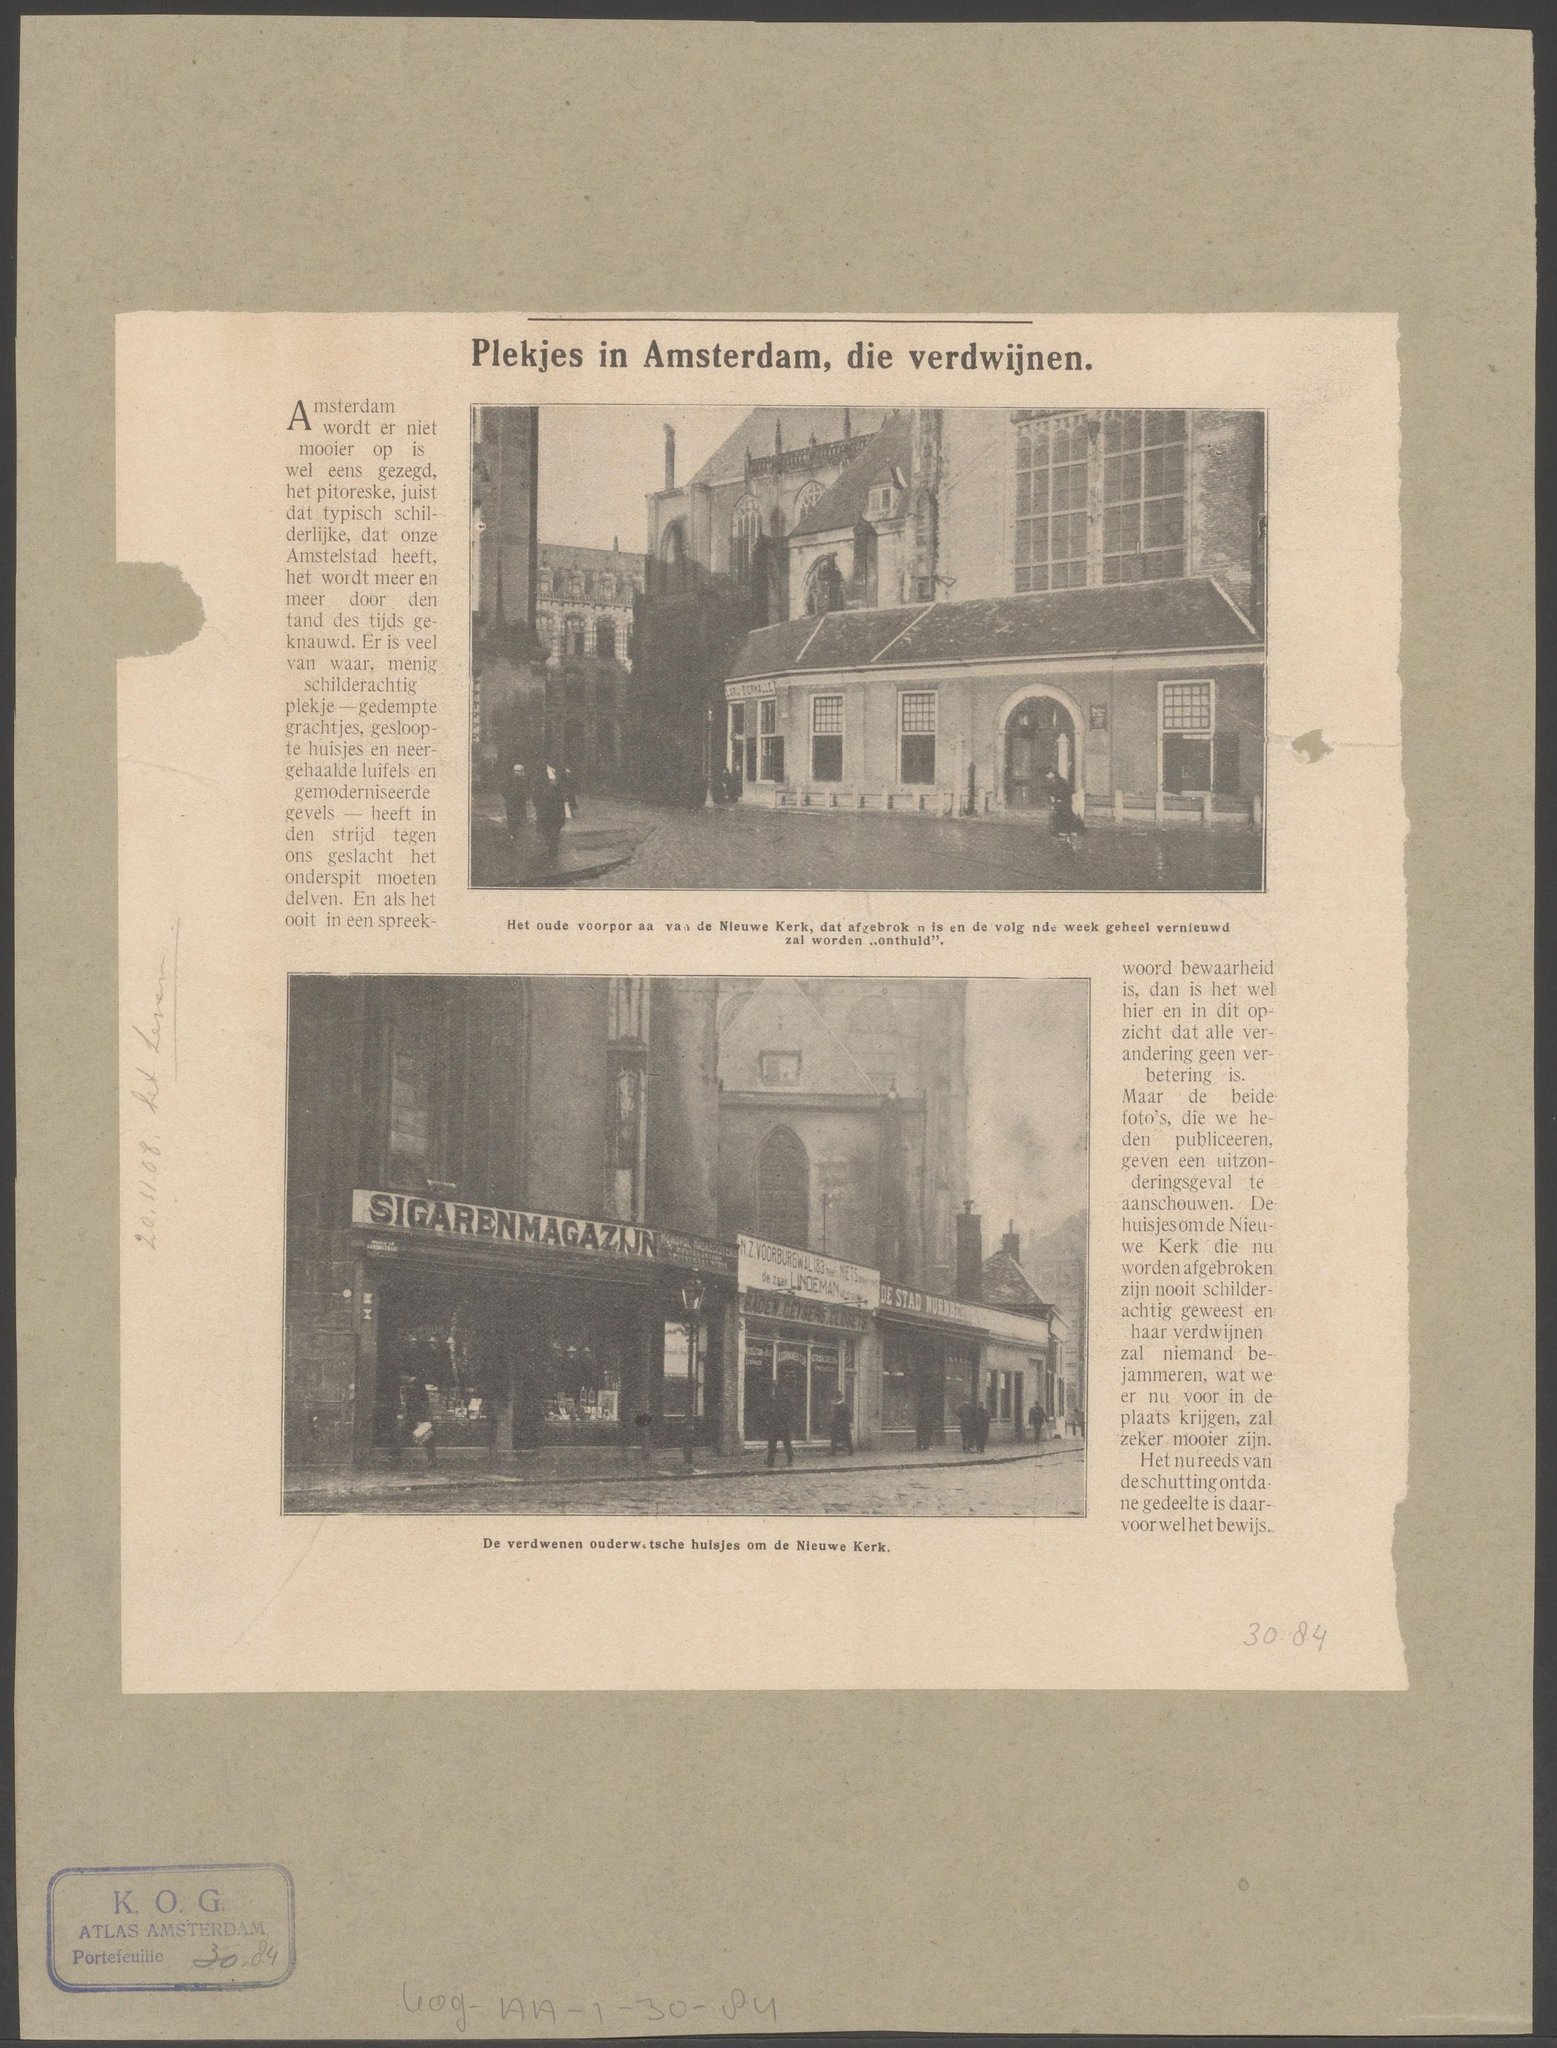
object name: photomechanical print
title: Gezicht op de Nieuwe Kerk te Amsterdam en aanpalende gebouwen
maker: Anonymous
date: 1908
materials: paper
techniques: letterpress printing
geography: netherlands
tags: parts of church exterior and annexes: portal, shop, store, church (exterior), street (+ city(-scape) with figures, staffage)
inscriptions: collector's mark: Lugt 1641b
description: Onderwerpsrubriek binnen de Atlas Amsterdam: Kerkwezen: Hervormde Gemeente: Nieuwe Kerk van buiten.